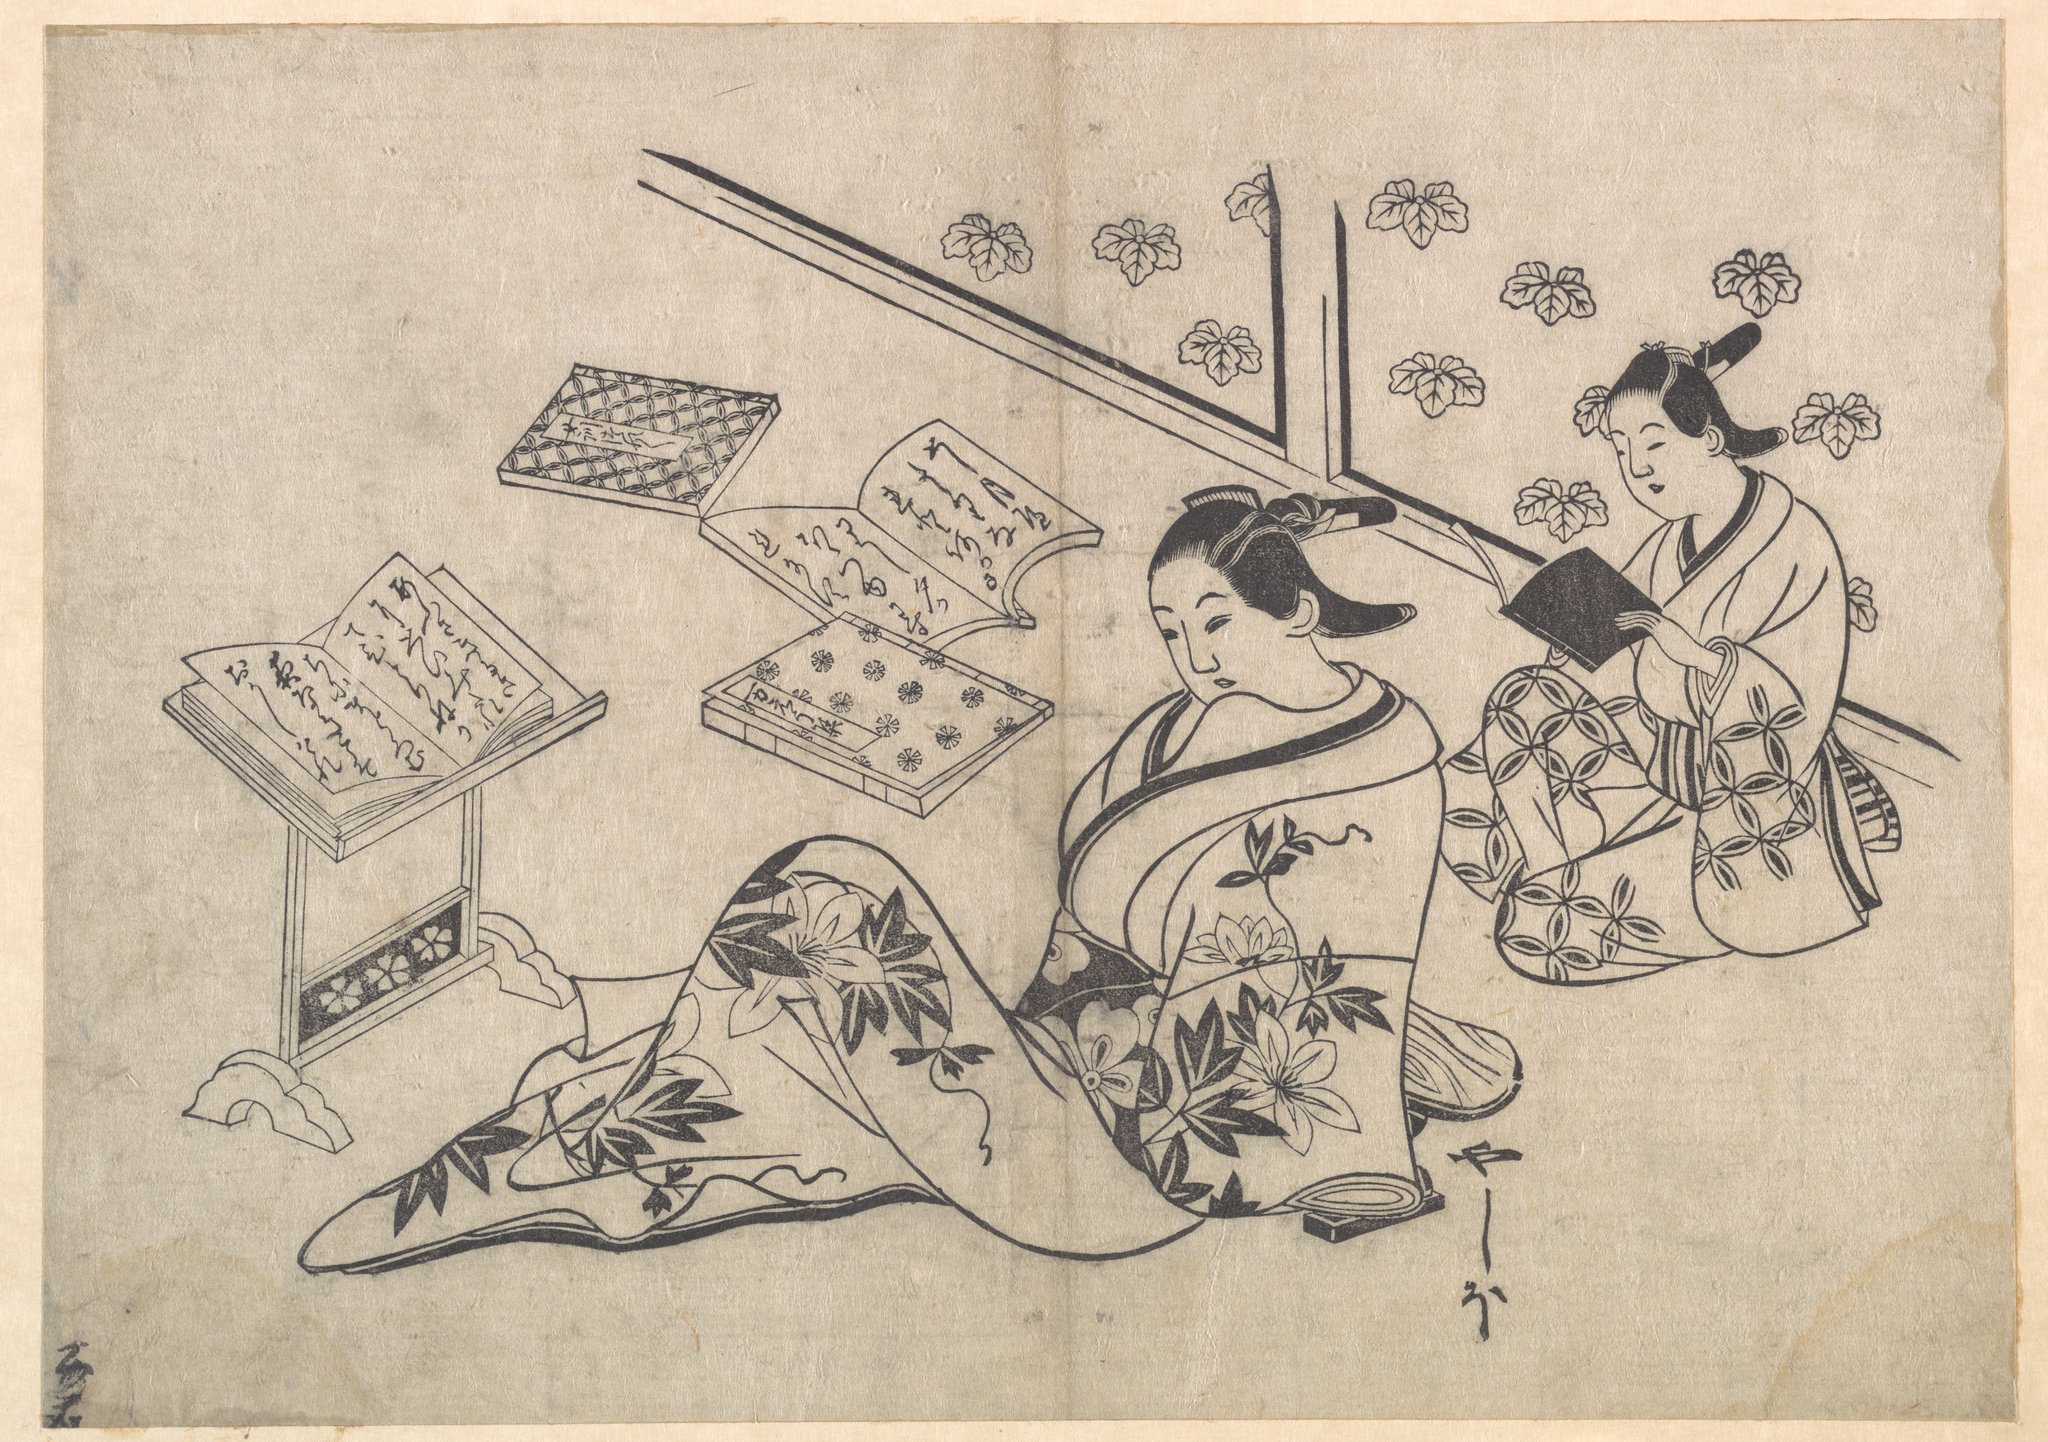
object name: print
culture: japanese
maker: hishikawa morofusa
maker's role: artist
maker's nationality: japanese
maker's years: 1685-1715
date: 1701-1733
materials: ink, paper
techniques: woodblock print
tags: books,women,reading